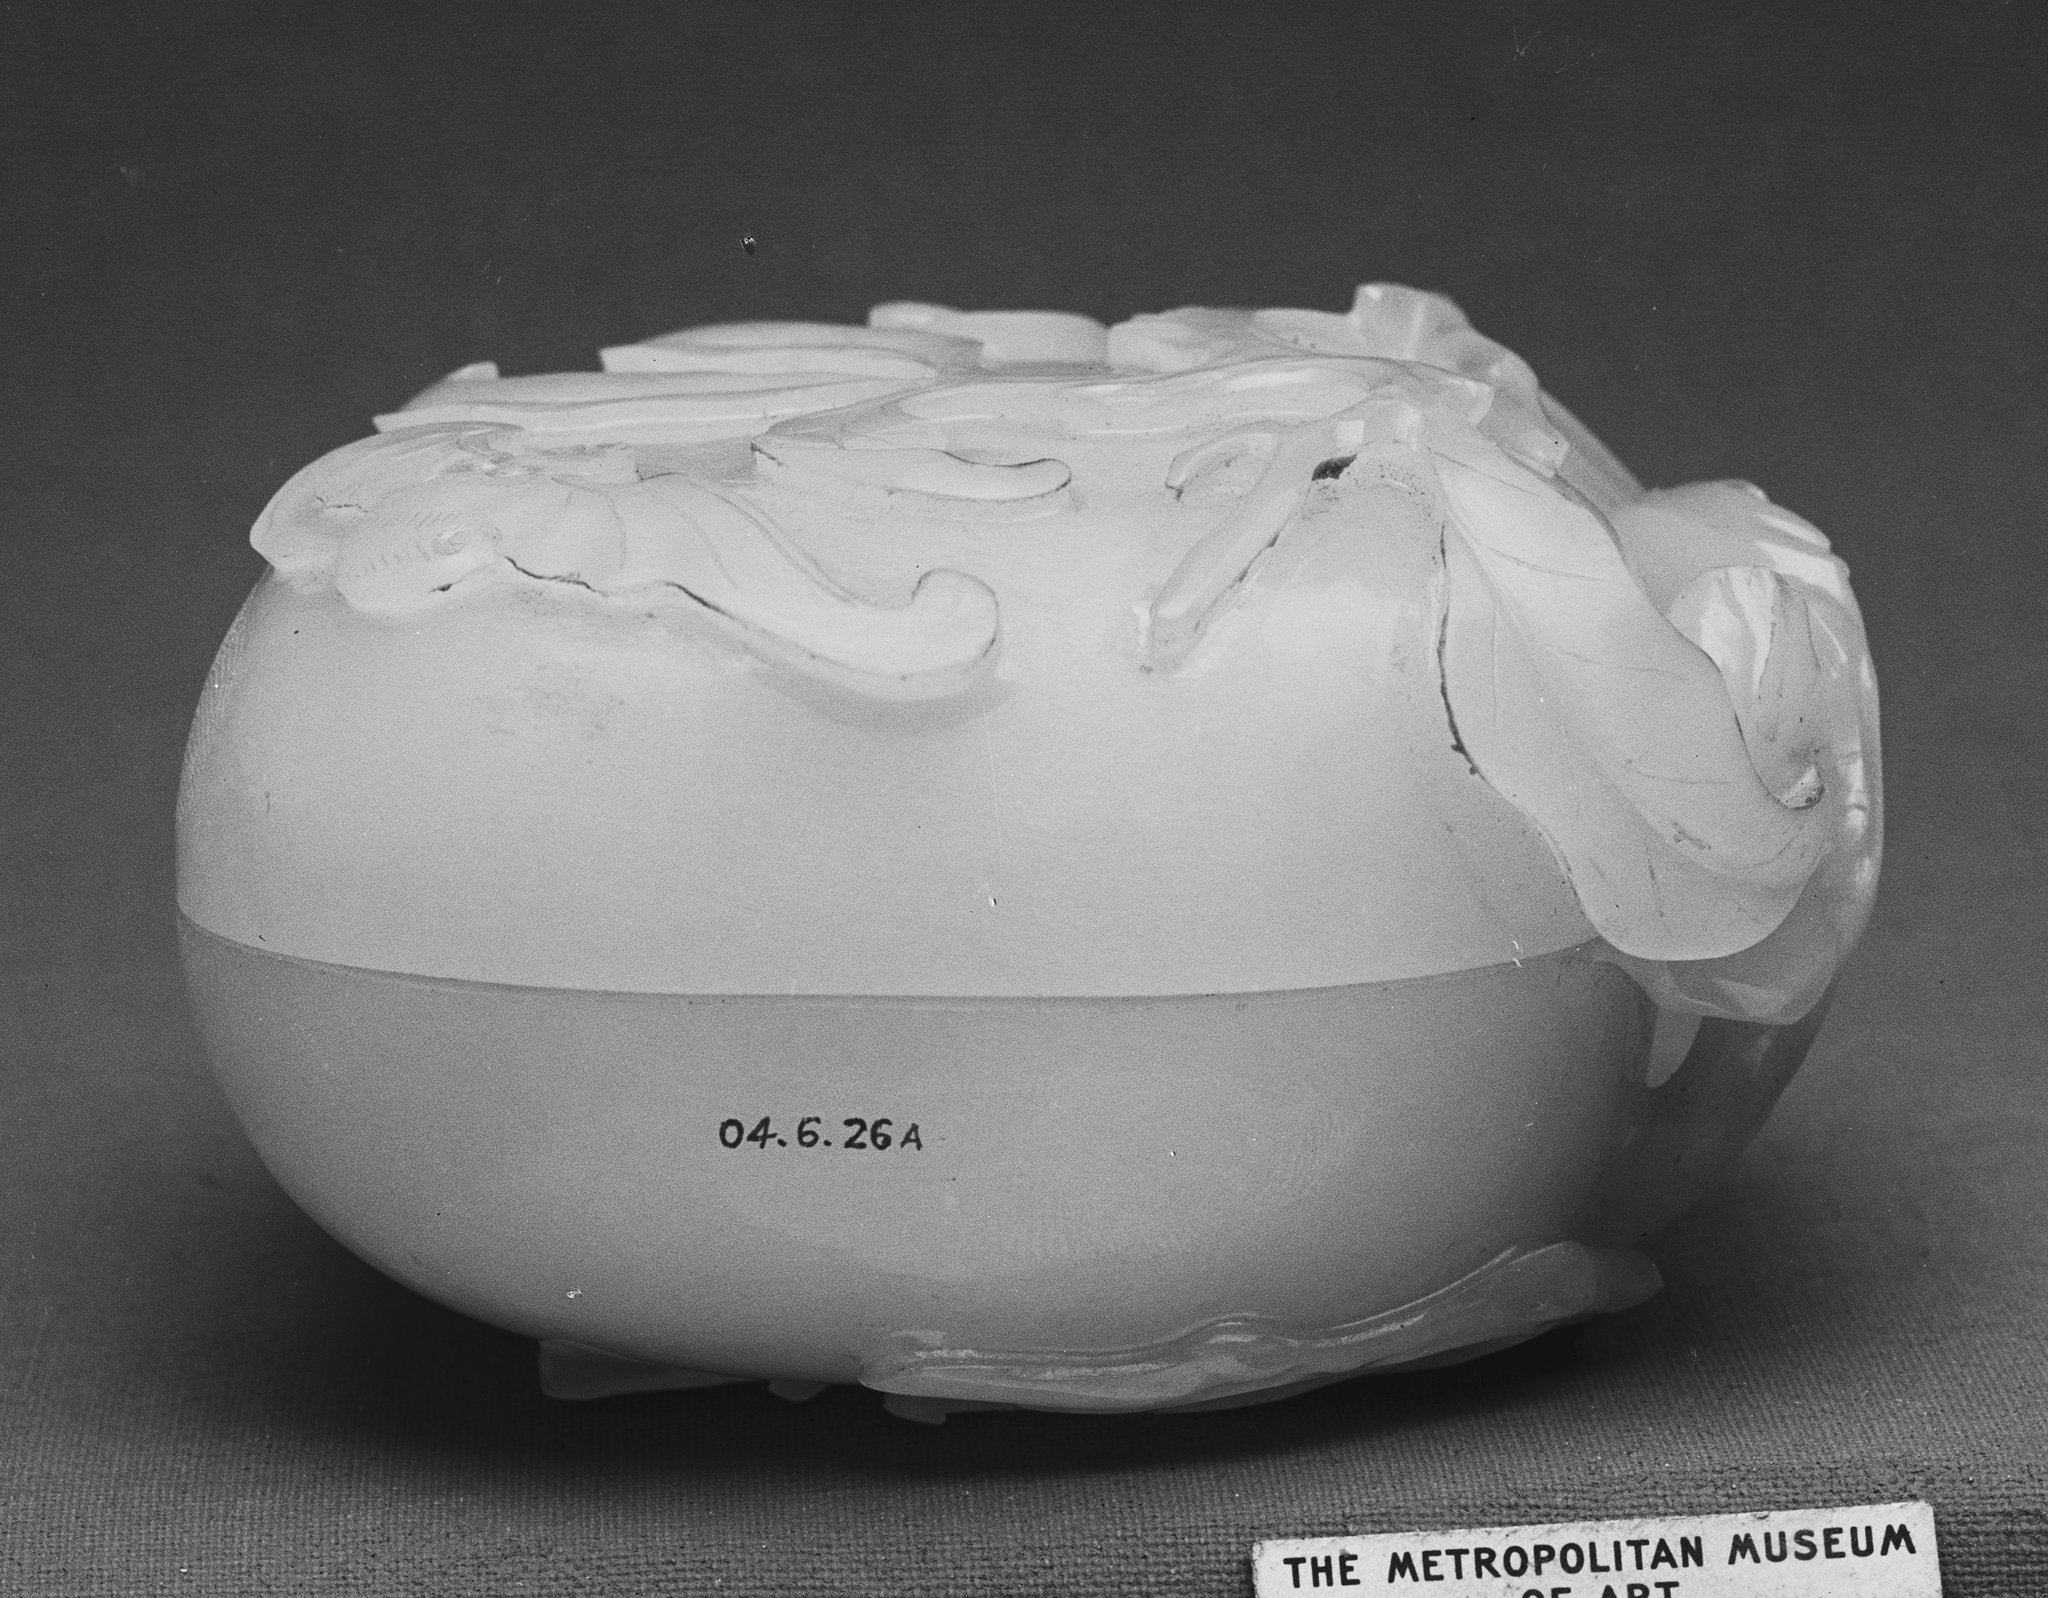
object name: box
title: Box in the shape of a peach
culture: chinese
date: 1701-1800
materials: jade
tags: leaves